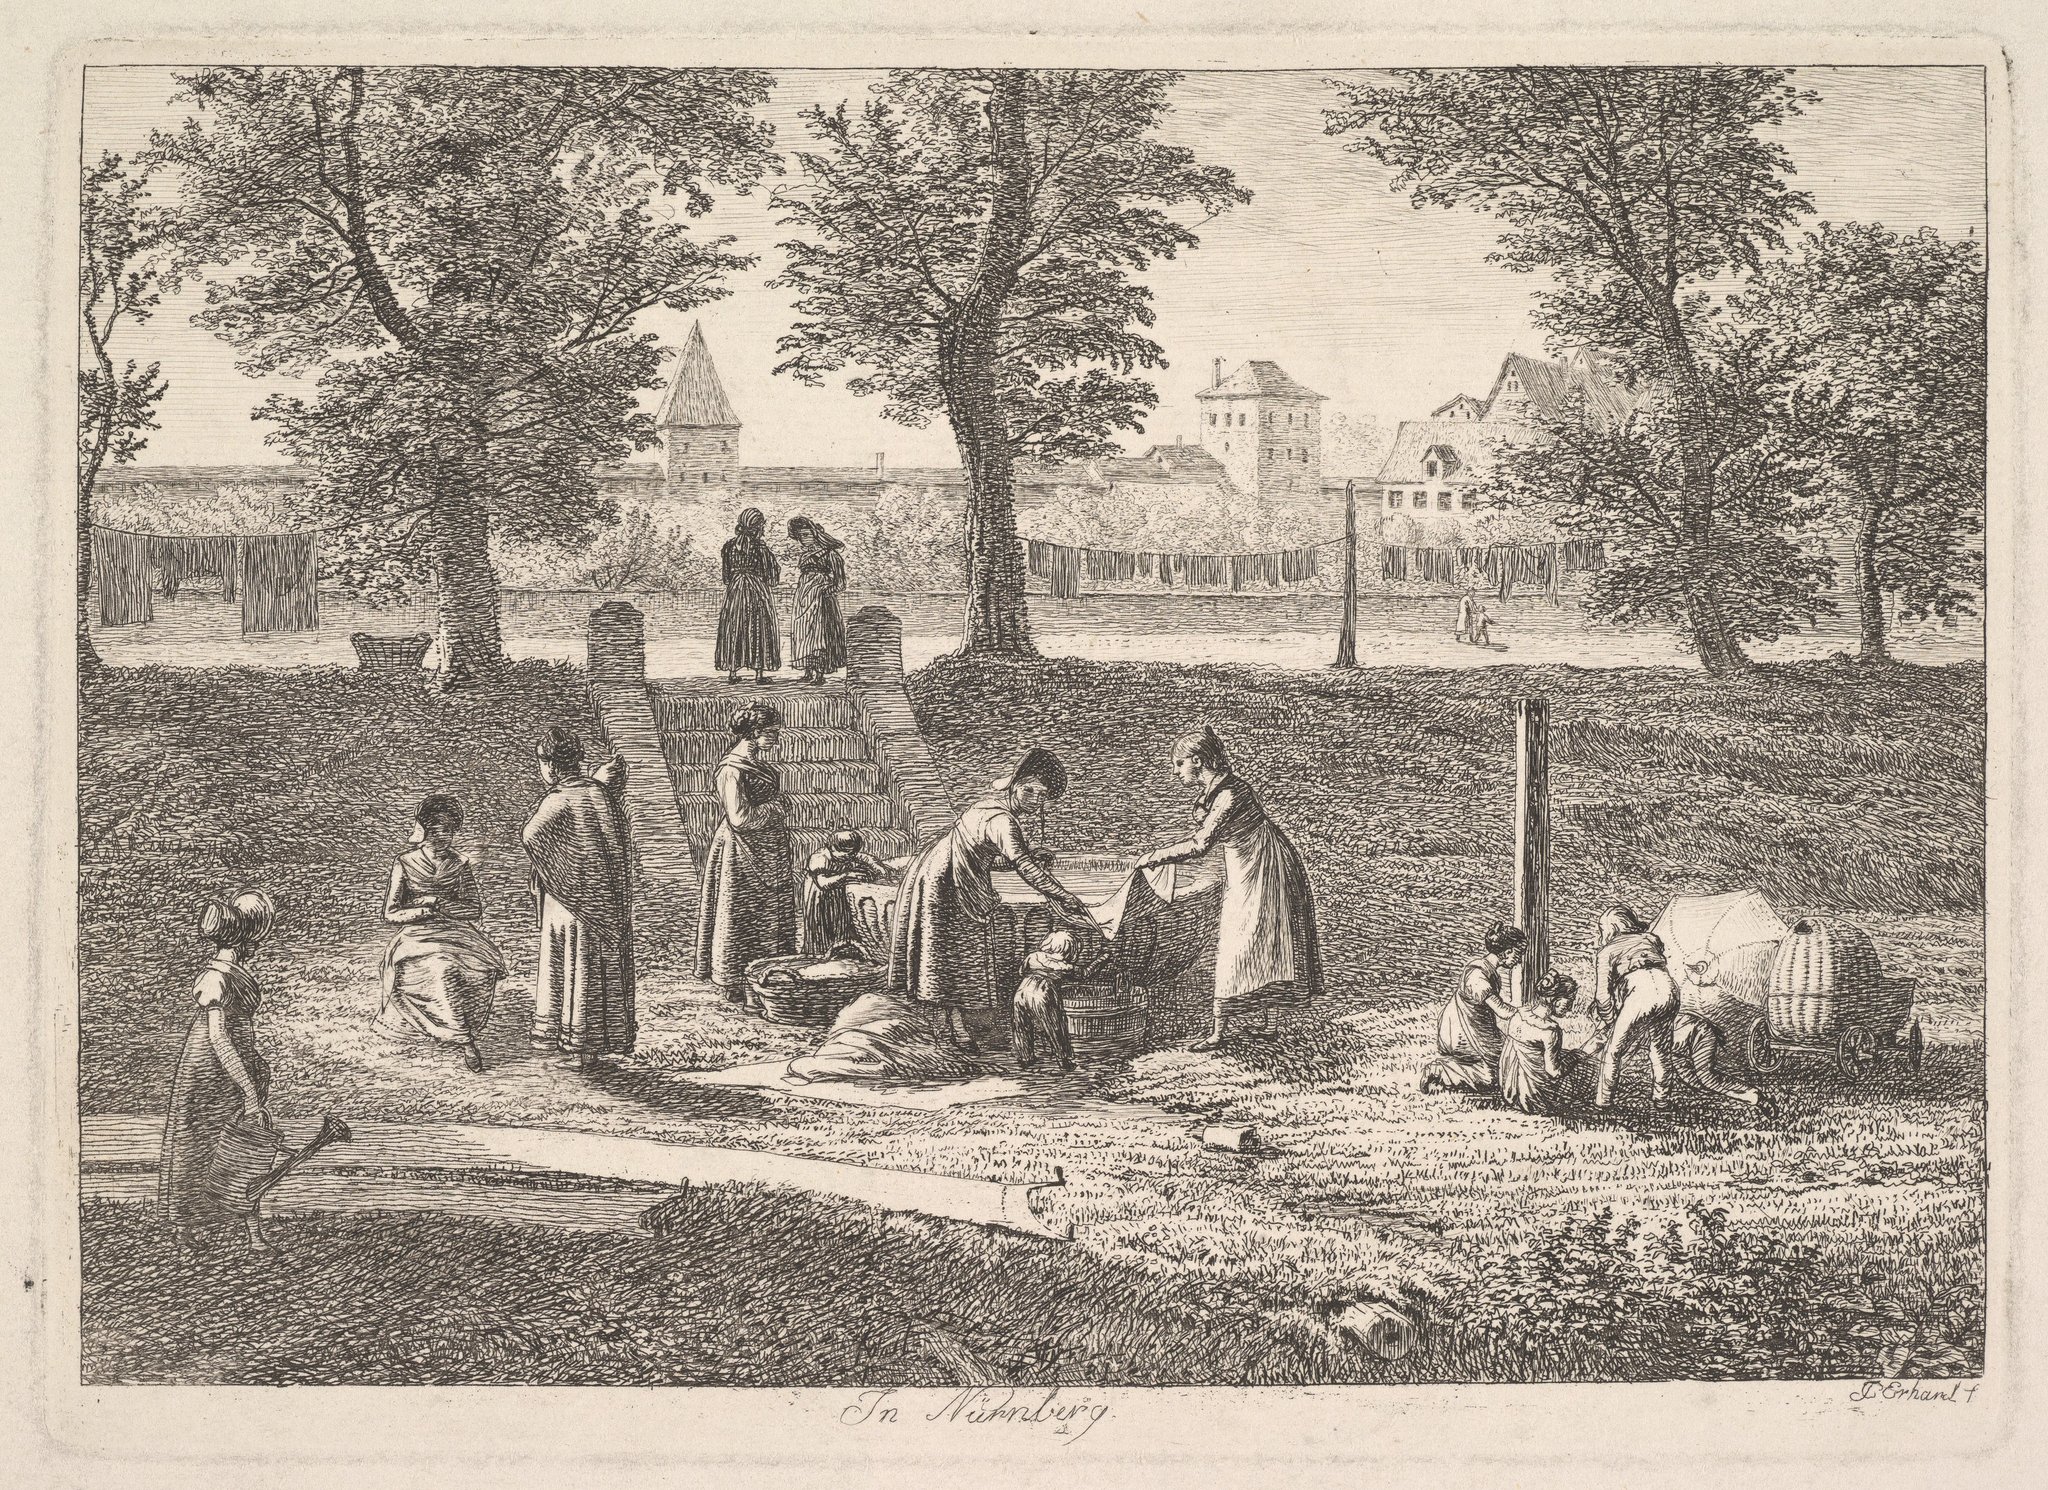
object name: print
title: Outdoor Scene of Women in Domestic Activities in Nurnberg,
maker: johann christoph erhard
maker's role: artist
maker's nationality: german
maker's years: 1795-1822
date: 1801-1900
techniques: etching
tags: women,working